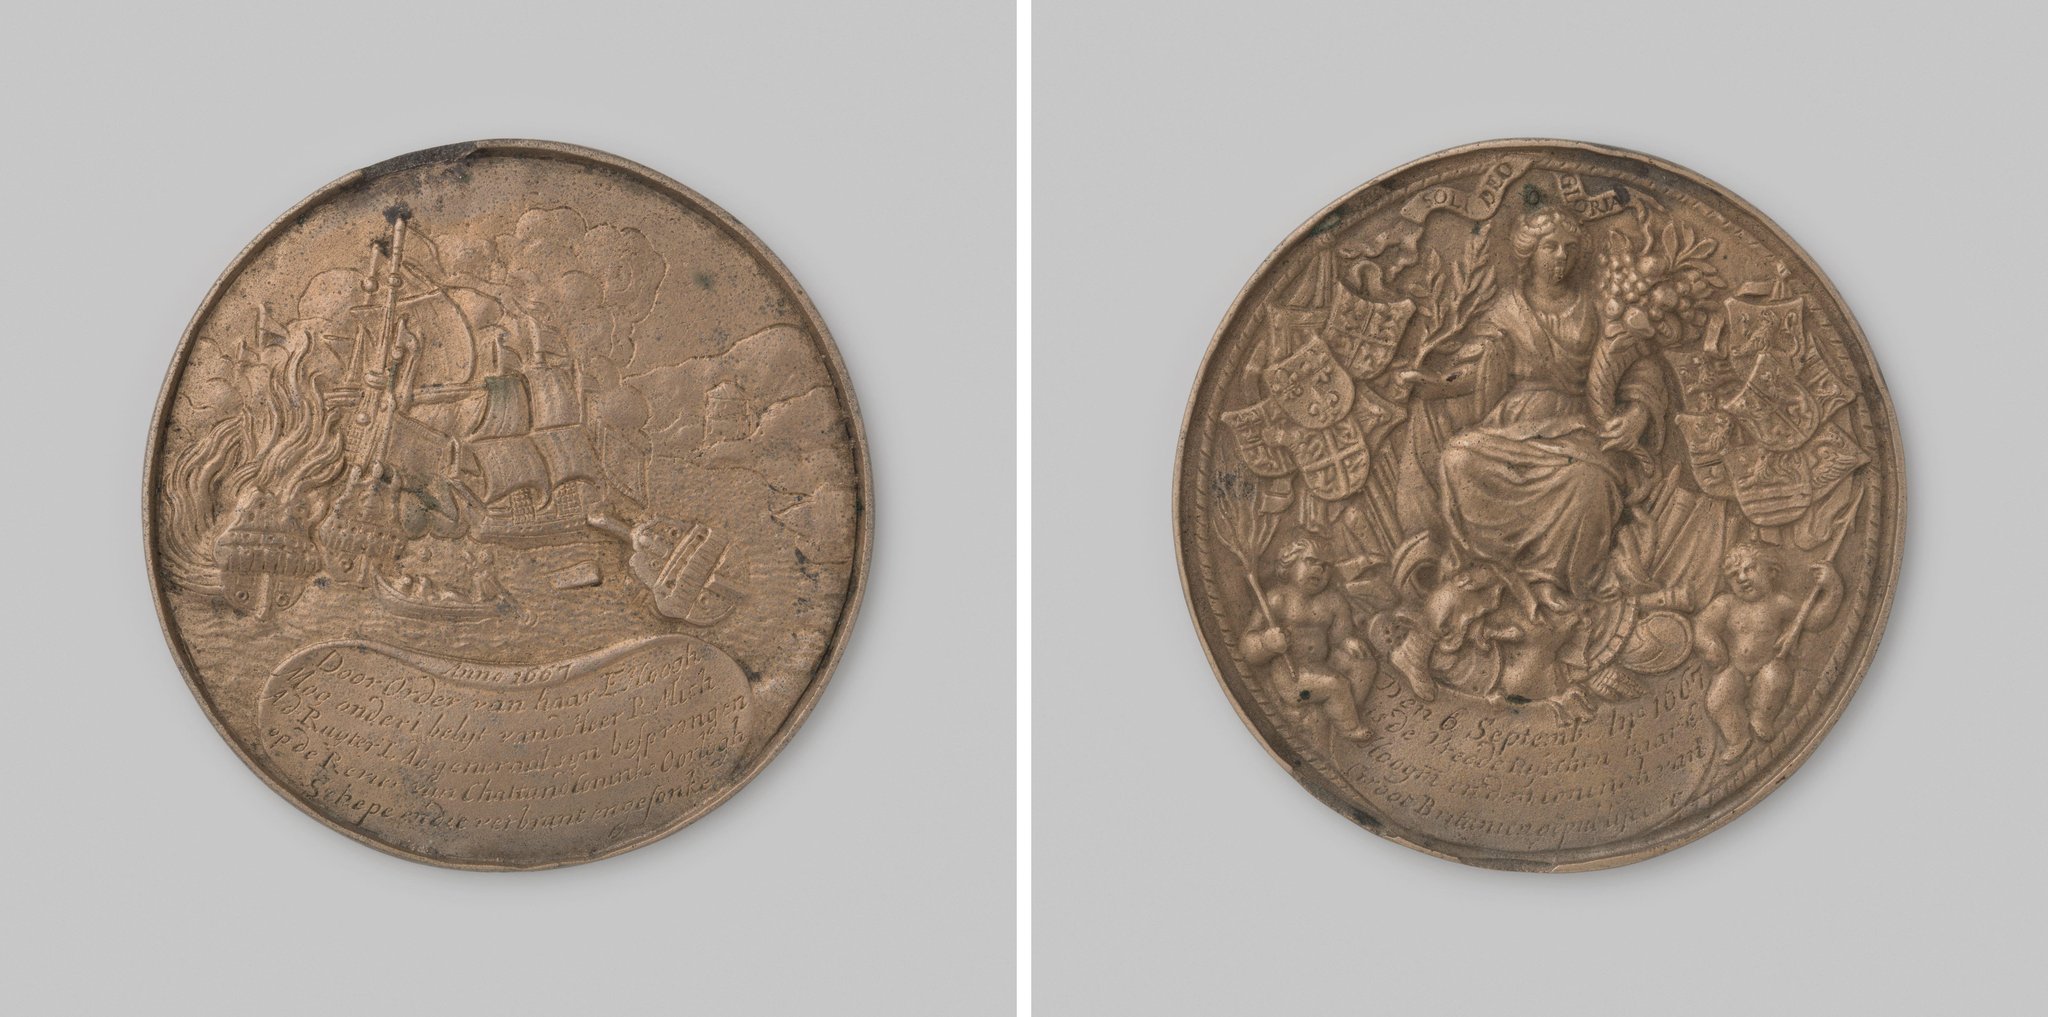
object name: history medal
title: Tocht naar Chatham door Michiel Adriaanszoon de Ruyter en de Vrede van Breda 1667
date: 1667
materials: silver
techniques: casting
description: Messing penning, op de voorzijde het verbranden van Engelse schepen waaronder een niervormig tekstbord, op de keerzijde de Vrede, met olijftak en hoorn des overvloeds, zittend op een stapel wapentuig tussen draperien met de provinciale wapenschilden, onderaan een tekst tussen twee kinderen met zweep en pijl.